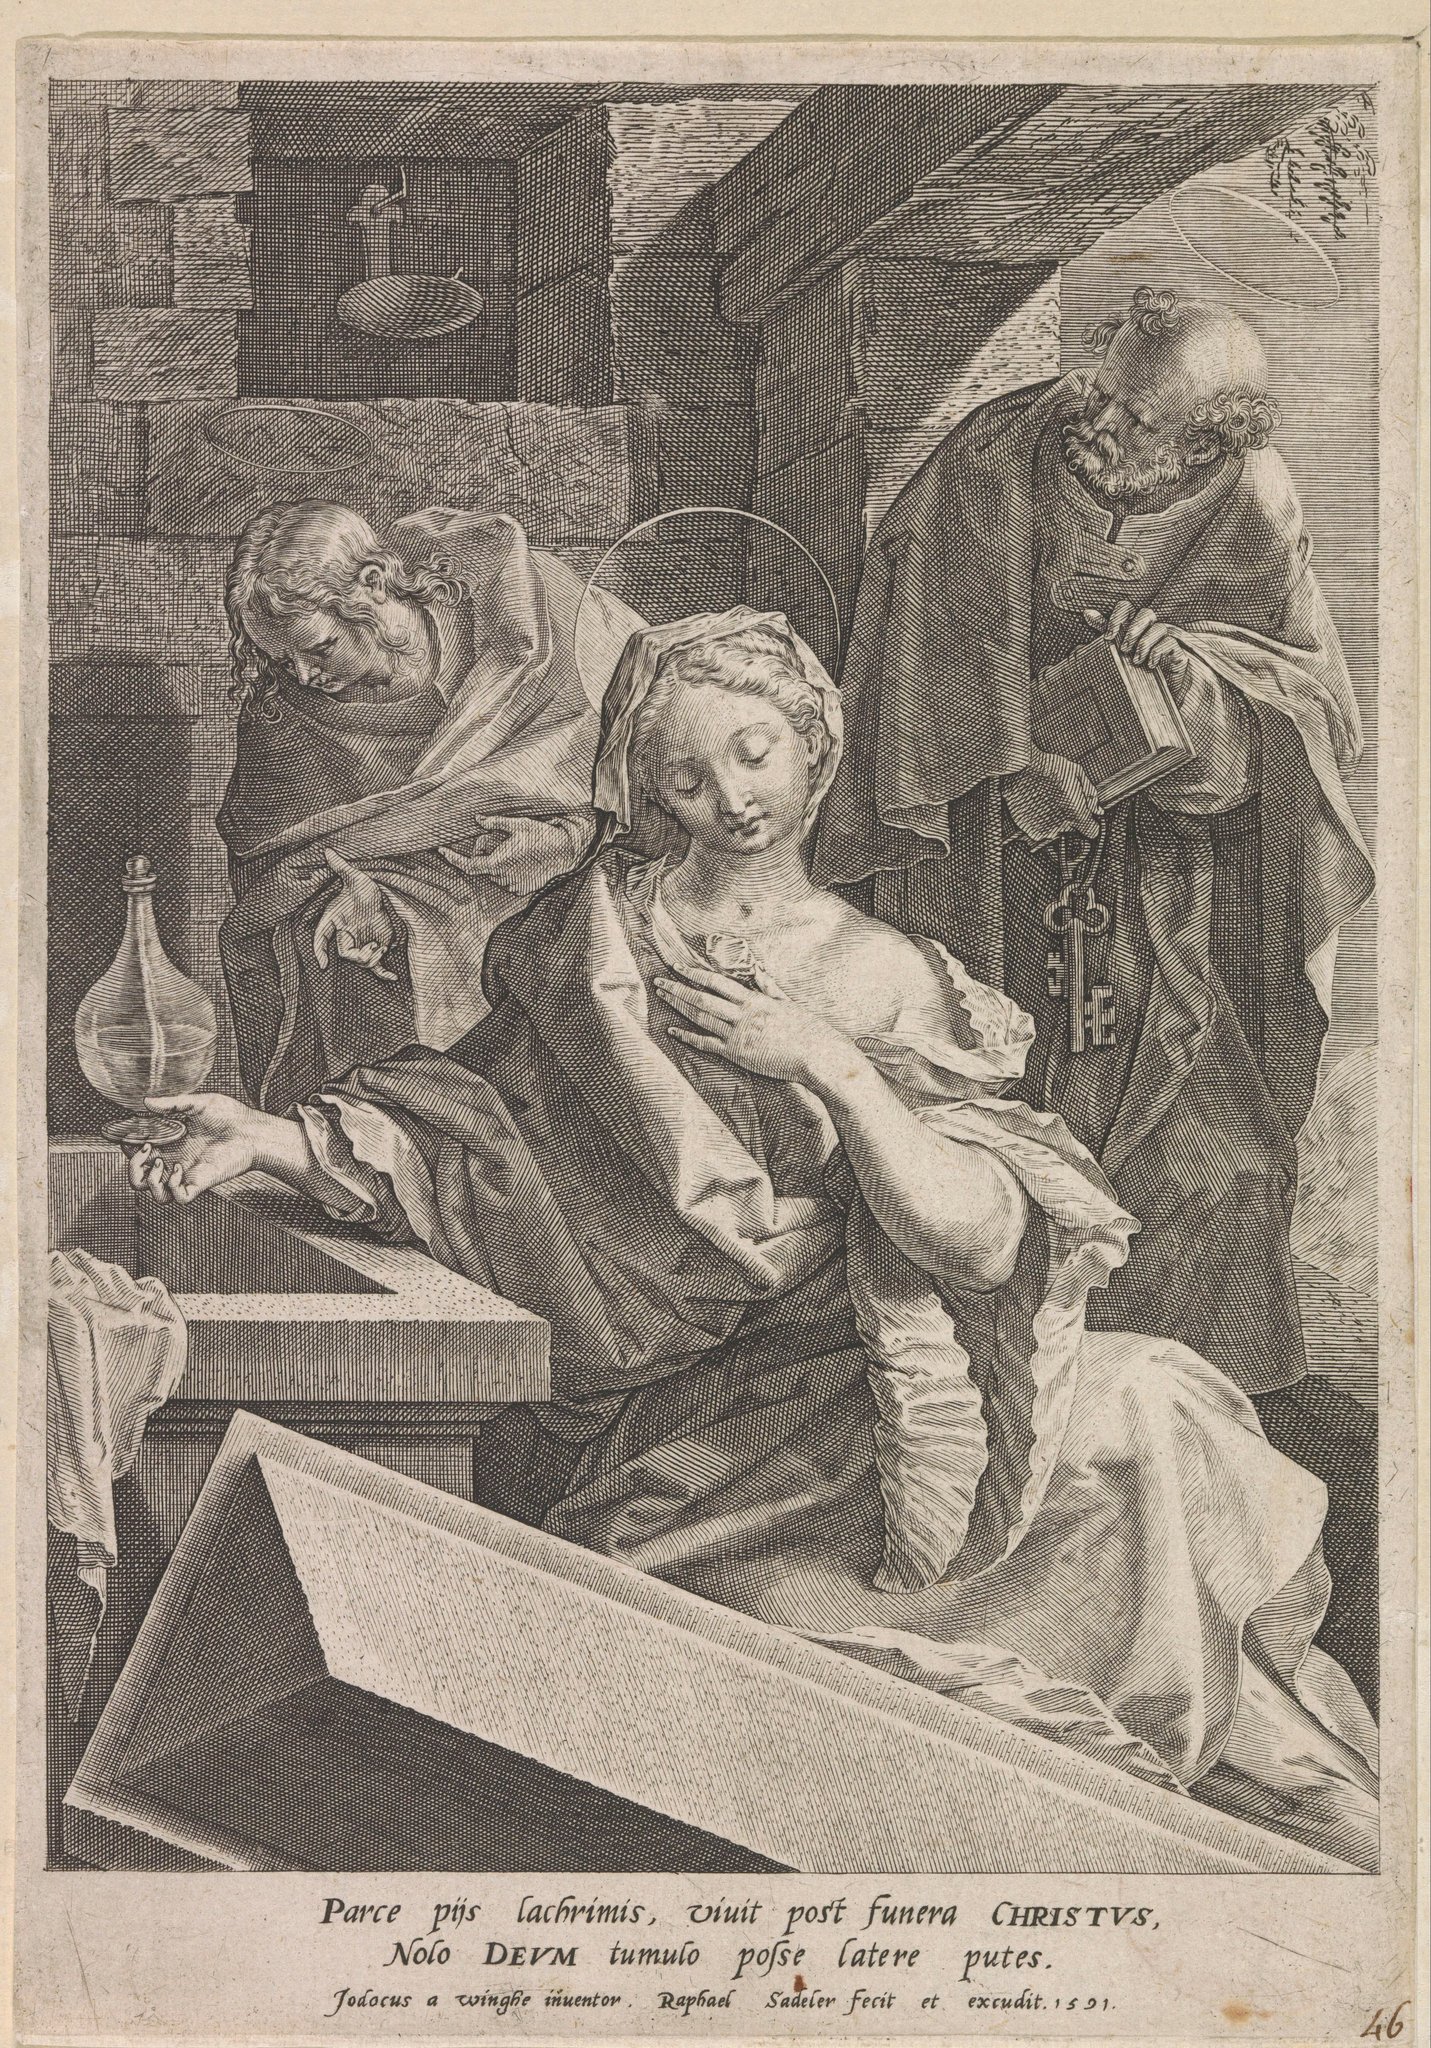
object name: print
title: Maria Magdalena en de apostelen Petrus en Johannes de evangelist bij het lege graf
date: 1591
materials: paper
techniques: engraving, etching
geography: frankfurt am main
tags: john, peter and mary magdalene approaching the open tomb of christ, the apostle john the evangelist; possible attributes: book, cauldron, chalice with snake, eagle, palm, scroll, the apostle peter, first bishop of rome; possible attributes: book, cock, (upturned) cross, (triple) crozier, fish, key, scroll, ship, tiara, the penitent harlot mary magdalene; possible attributes: book (or scroll), crown, crown of thorns, crucifix, jar of ointment, mirror, musical instrument, palm-branch, rosary, scourge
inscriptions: number: ‘46’, collector's mark: Lugt 240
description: Maria Magdalena zit bij het lege graf. Achter haar staan de apostelen Petrus en Johannes de evangelist.